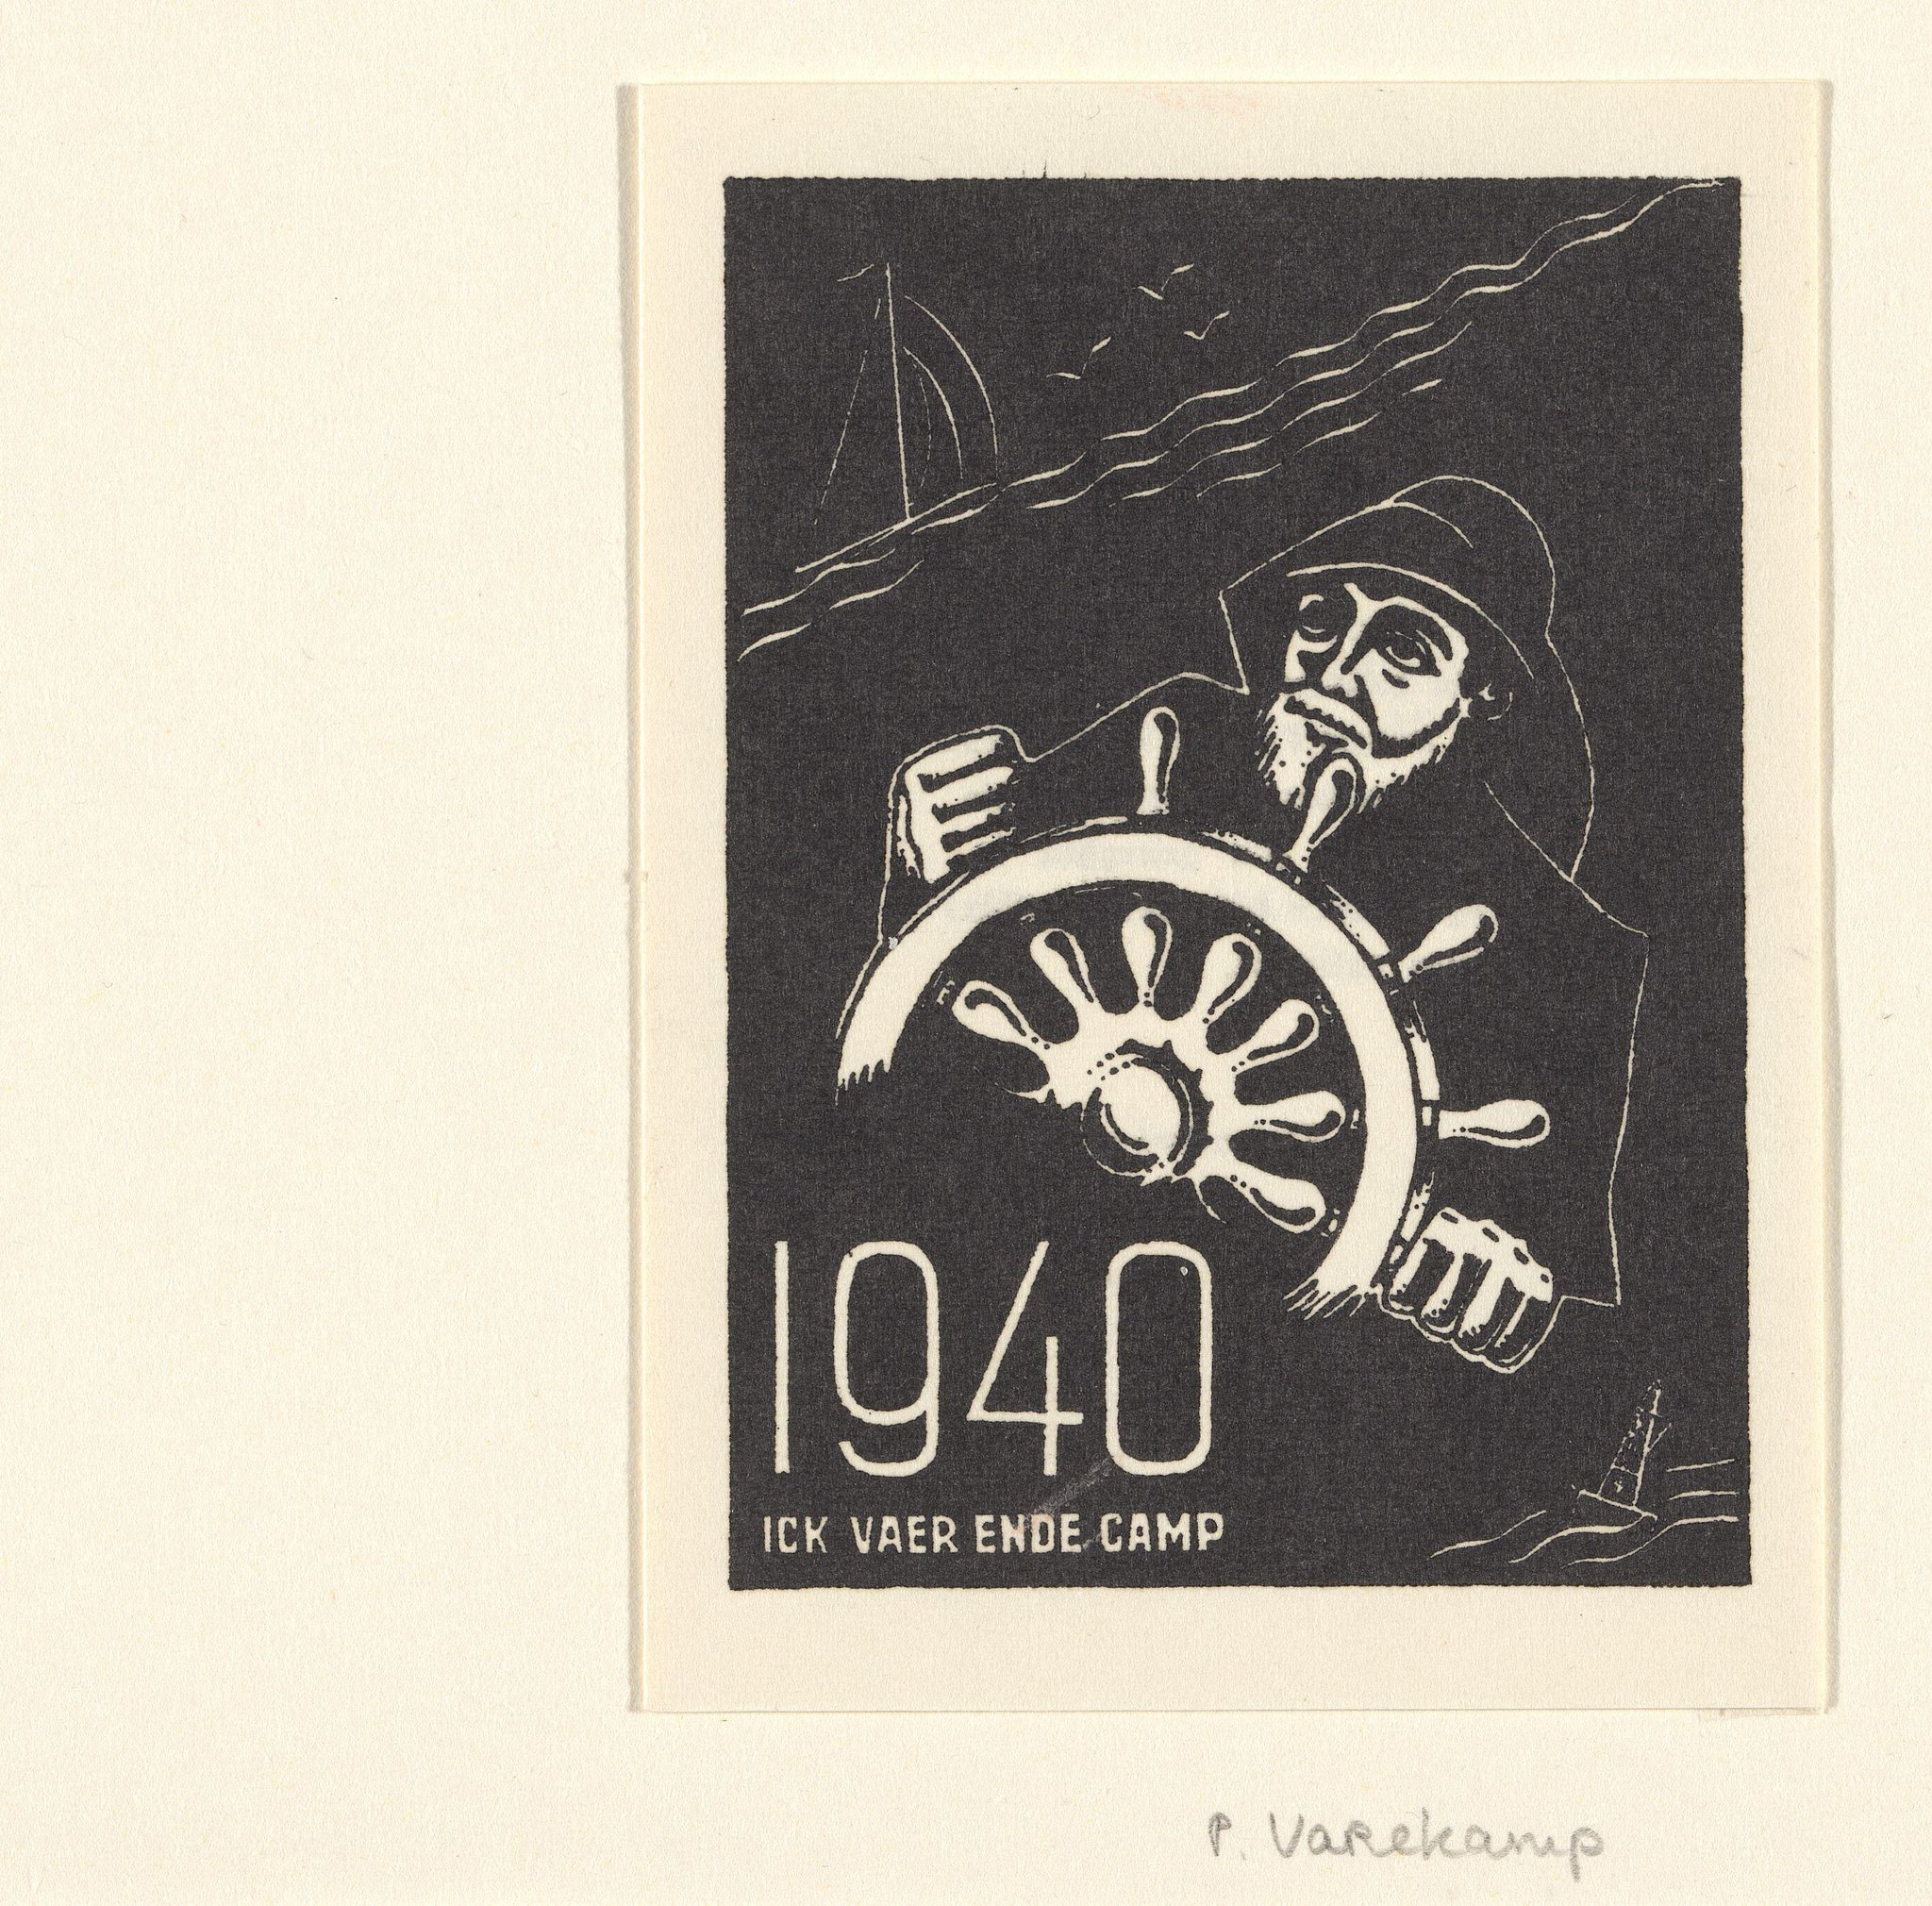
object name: print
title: Plafondschildering met vergadering van goden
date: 1717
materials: paper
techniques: engraving, etching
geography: france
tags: (story of) pan, roman deities, and foreign deities included in the classical pantheon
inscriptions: collector's mark: Lugt 240, collector's mark: Lugt 1838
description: Dit object is omwille van een betere presentatie virtueel samengevoegd, maar bestaat fysiek uit losse onderdelen.